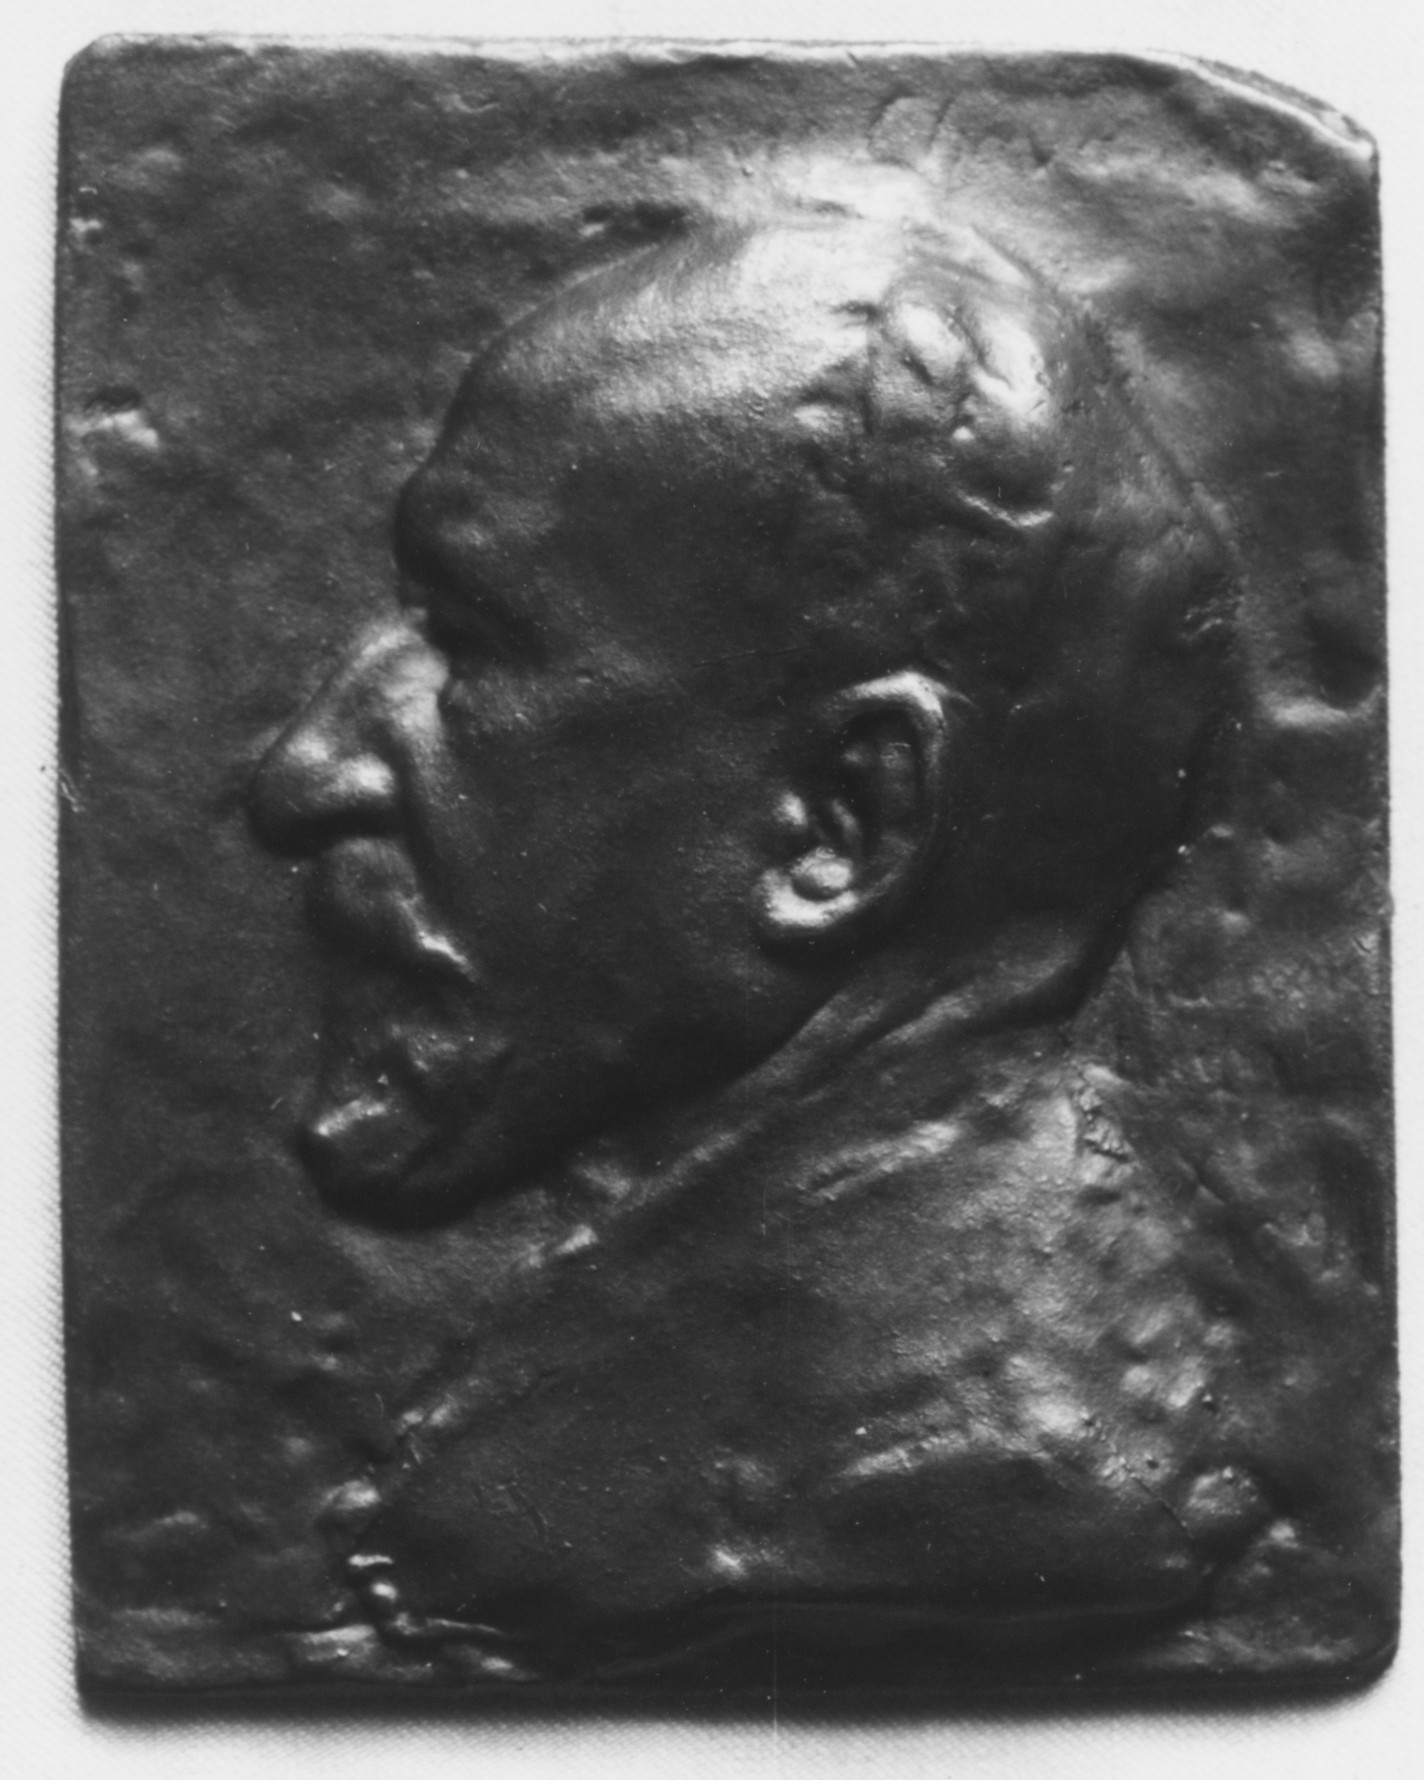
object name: plaquette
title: Portrait of Pierre Puvis de Chavannes (1824–1898), greatest of French decorative painters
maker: alexandre-louis-marie charpentier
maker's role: artist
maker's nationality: french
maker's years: 1856-1909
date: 1867-1900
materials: bronze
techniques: casting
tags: men,profiles